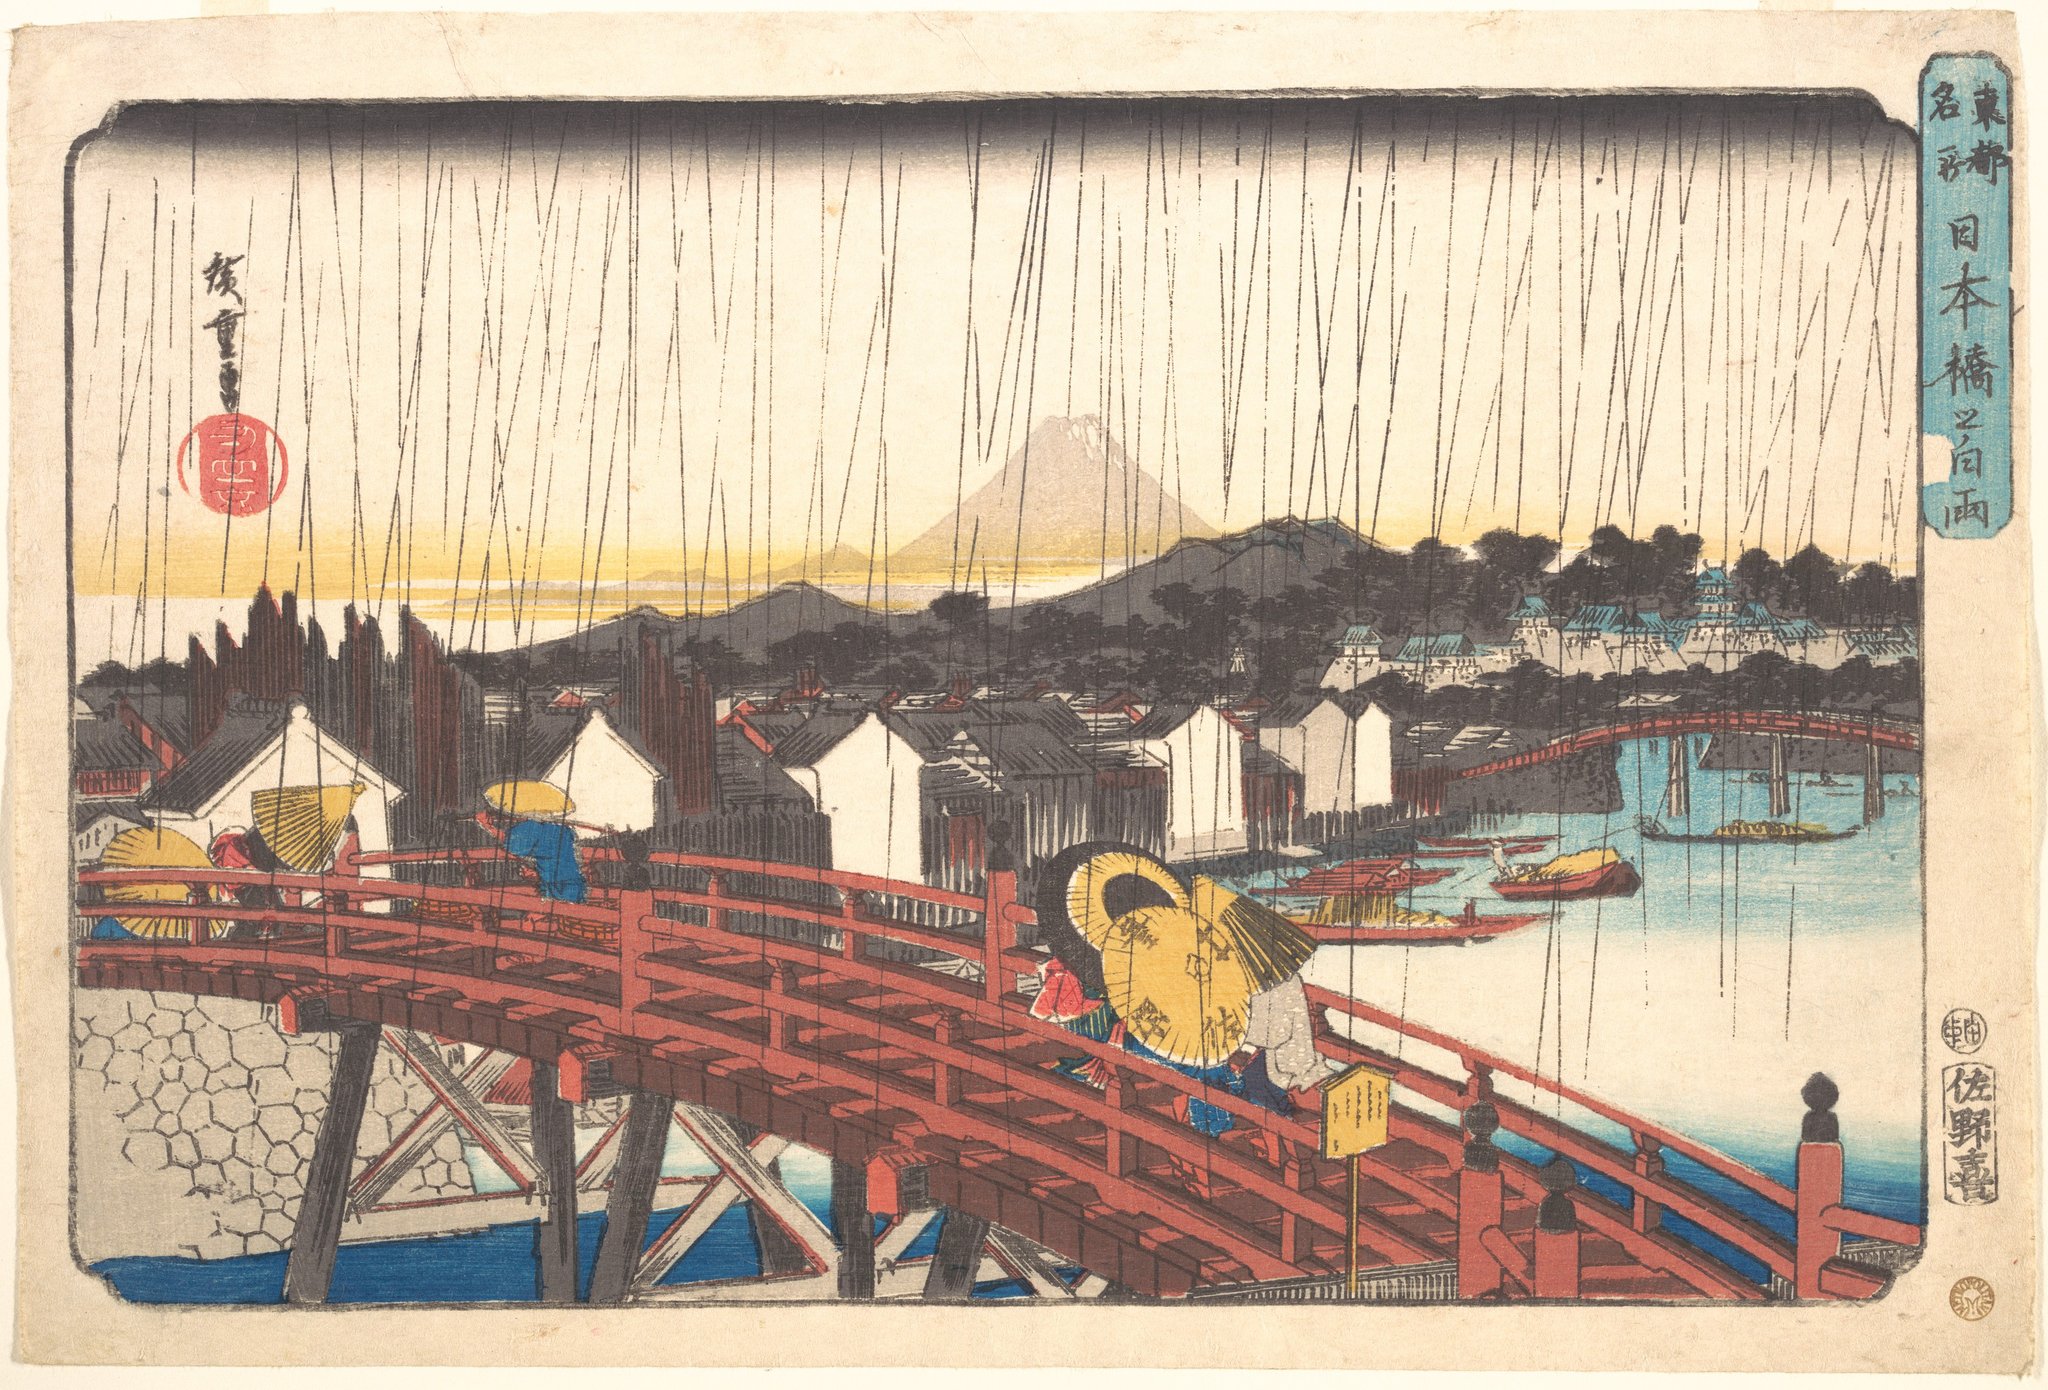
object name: print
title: Sunshower at Nihonbashi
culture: japanese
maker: utagawa hiroshige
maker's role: artist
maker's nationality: japanese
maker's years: 1797-1858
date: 1833-1834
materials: ink, paper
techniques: woodblock print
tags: houses,bridges,mountains,rain,boats